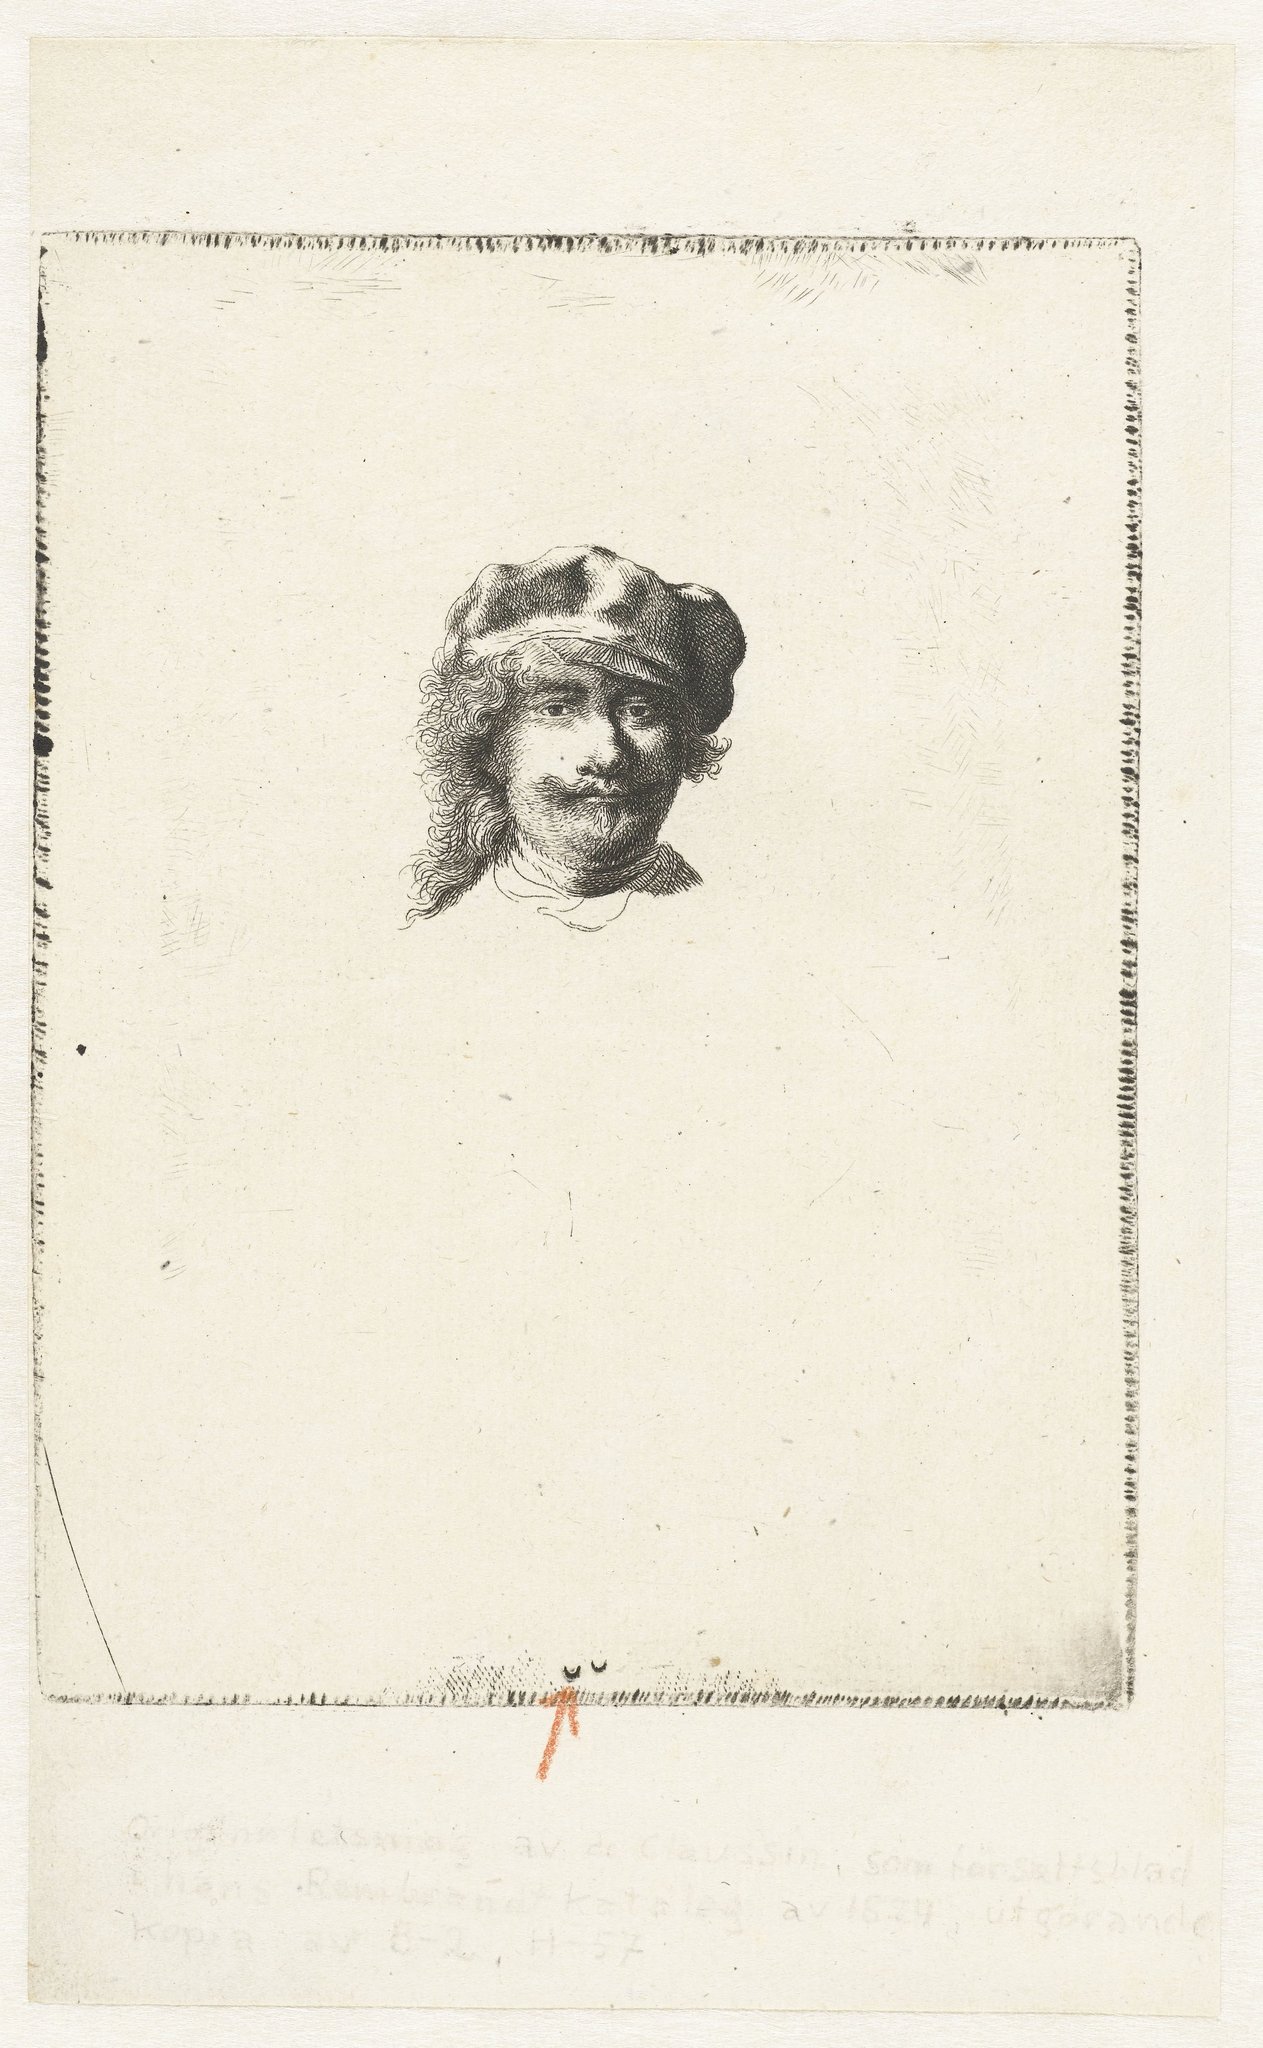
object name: print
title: Self-portrait wearing a soft cap: full face, head only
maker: ignace-joseph de claussin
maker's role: print maker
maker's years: 1766-1844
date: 1805-1844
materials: paper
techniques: etching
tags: leiden, amsterdam, painter, draughtsman, rembrandt van rijn, portrait, self-portrait of graphic artist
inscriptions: collector's mark: Lugt 2228, inscription:, collector's mark: Lugt 2760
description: Spiegelbeeldige kopie naar de gelijknamige prent van Rembrandt.